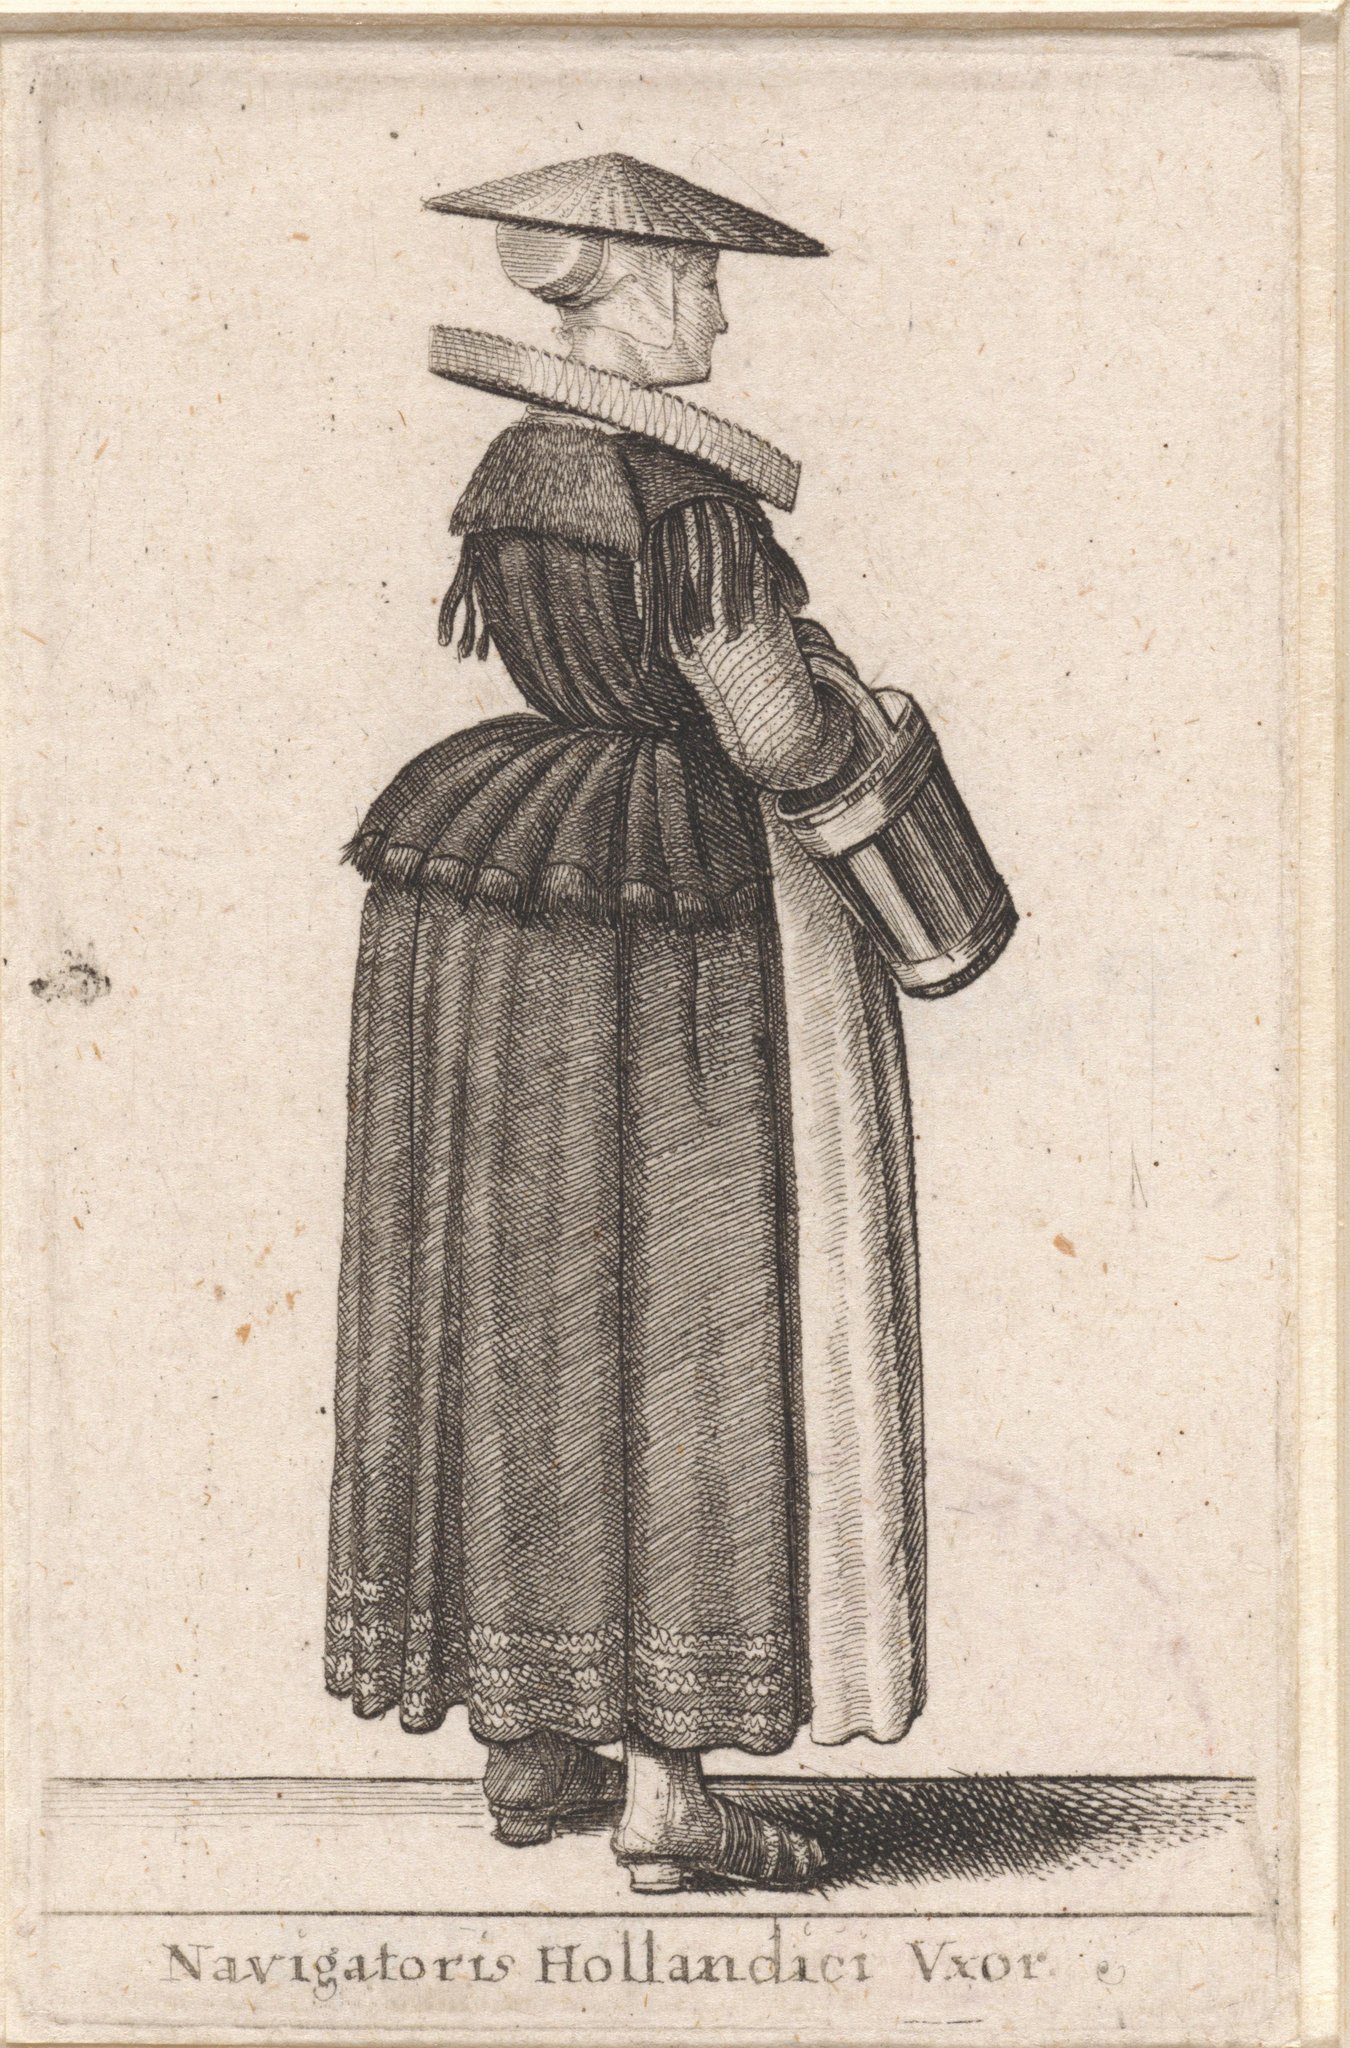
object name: costume print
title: Navigatoris Hollandici Vxor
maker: wenceslaus hollar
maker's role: draughtsman, print maker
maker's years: 1607-1677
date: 1644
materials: paper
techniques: etching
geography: london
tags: europeans (dutch) (+ women), clothes, costume (+ women's clothes), head-gear: hat (+ women's clothes), shoes, sandals (+ women's clothes), neck-gear ~ clothing (with name) (+ women's clothes), carrying something in basket, bag, rucksack, etc., skirt (+ women's clothes), apron (+ women's clothes), clothing for the upper part of the body (with name) (+ women's clothes), holland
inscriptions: collector's mark: Lugt 240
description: Schippersvrouw uit Holland, staand naar rechts, half op de rug gezien, een marktemmer (spanen met metalen hoepels) aan de rechterarm. Over een aan weerszijden van het gezicht uitstaande muts een grote, ronde punthoed. Brede plooikraag. Mouwloos, getailleerd jak langs de zoom afgezet met bont. Sluik vallende, enkellange rok over beuling waarover wit schort. Muilen met blokhak. no. 3 uit serie van twaalf kostuums uit verschillende landen. (vergelijk NHG. 612)